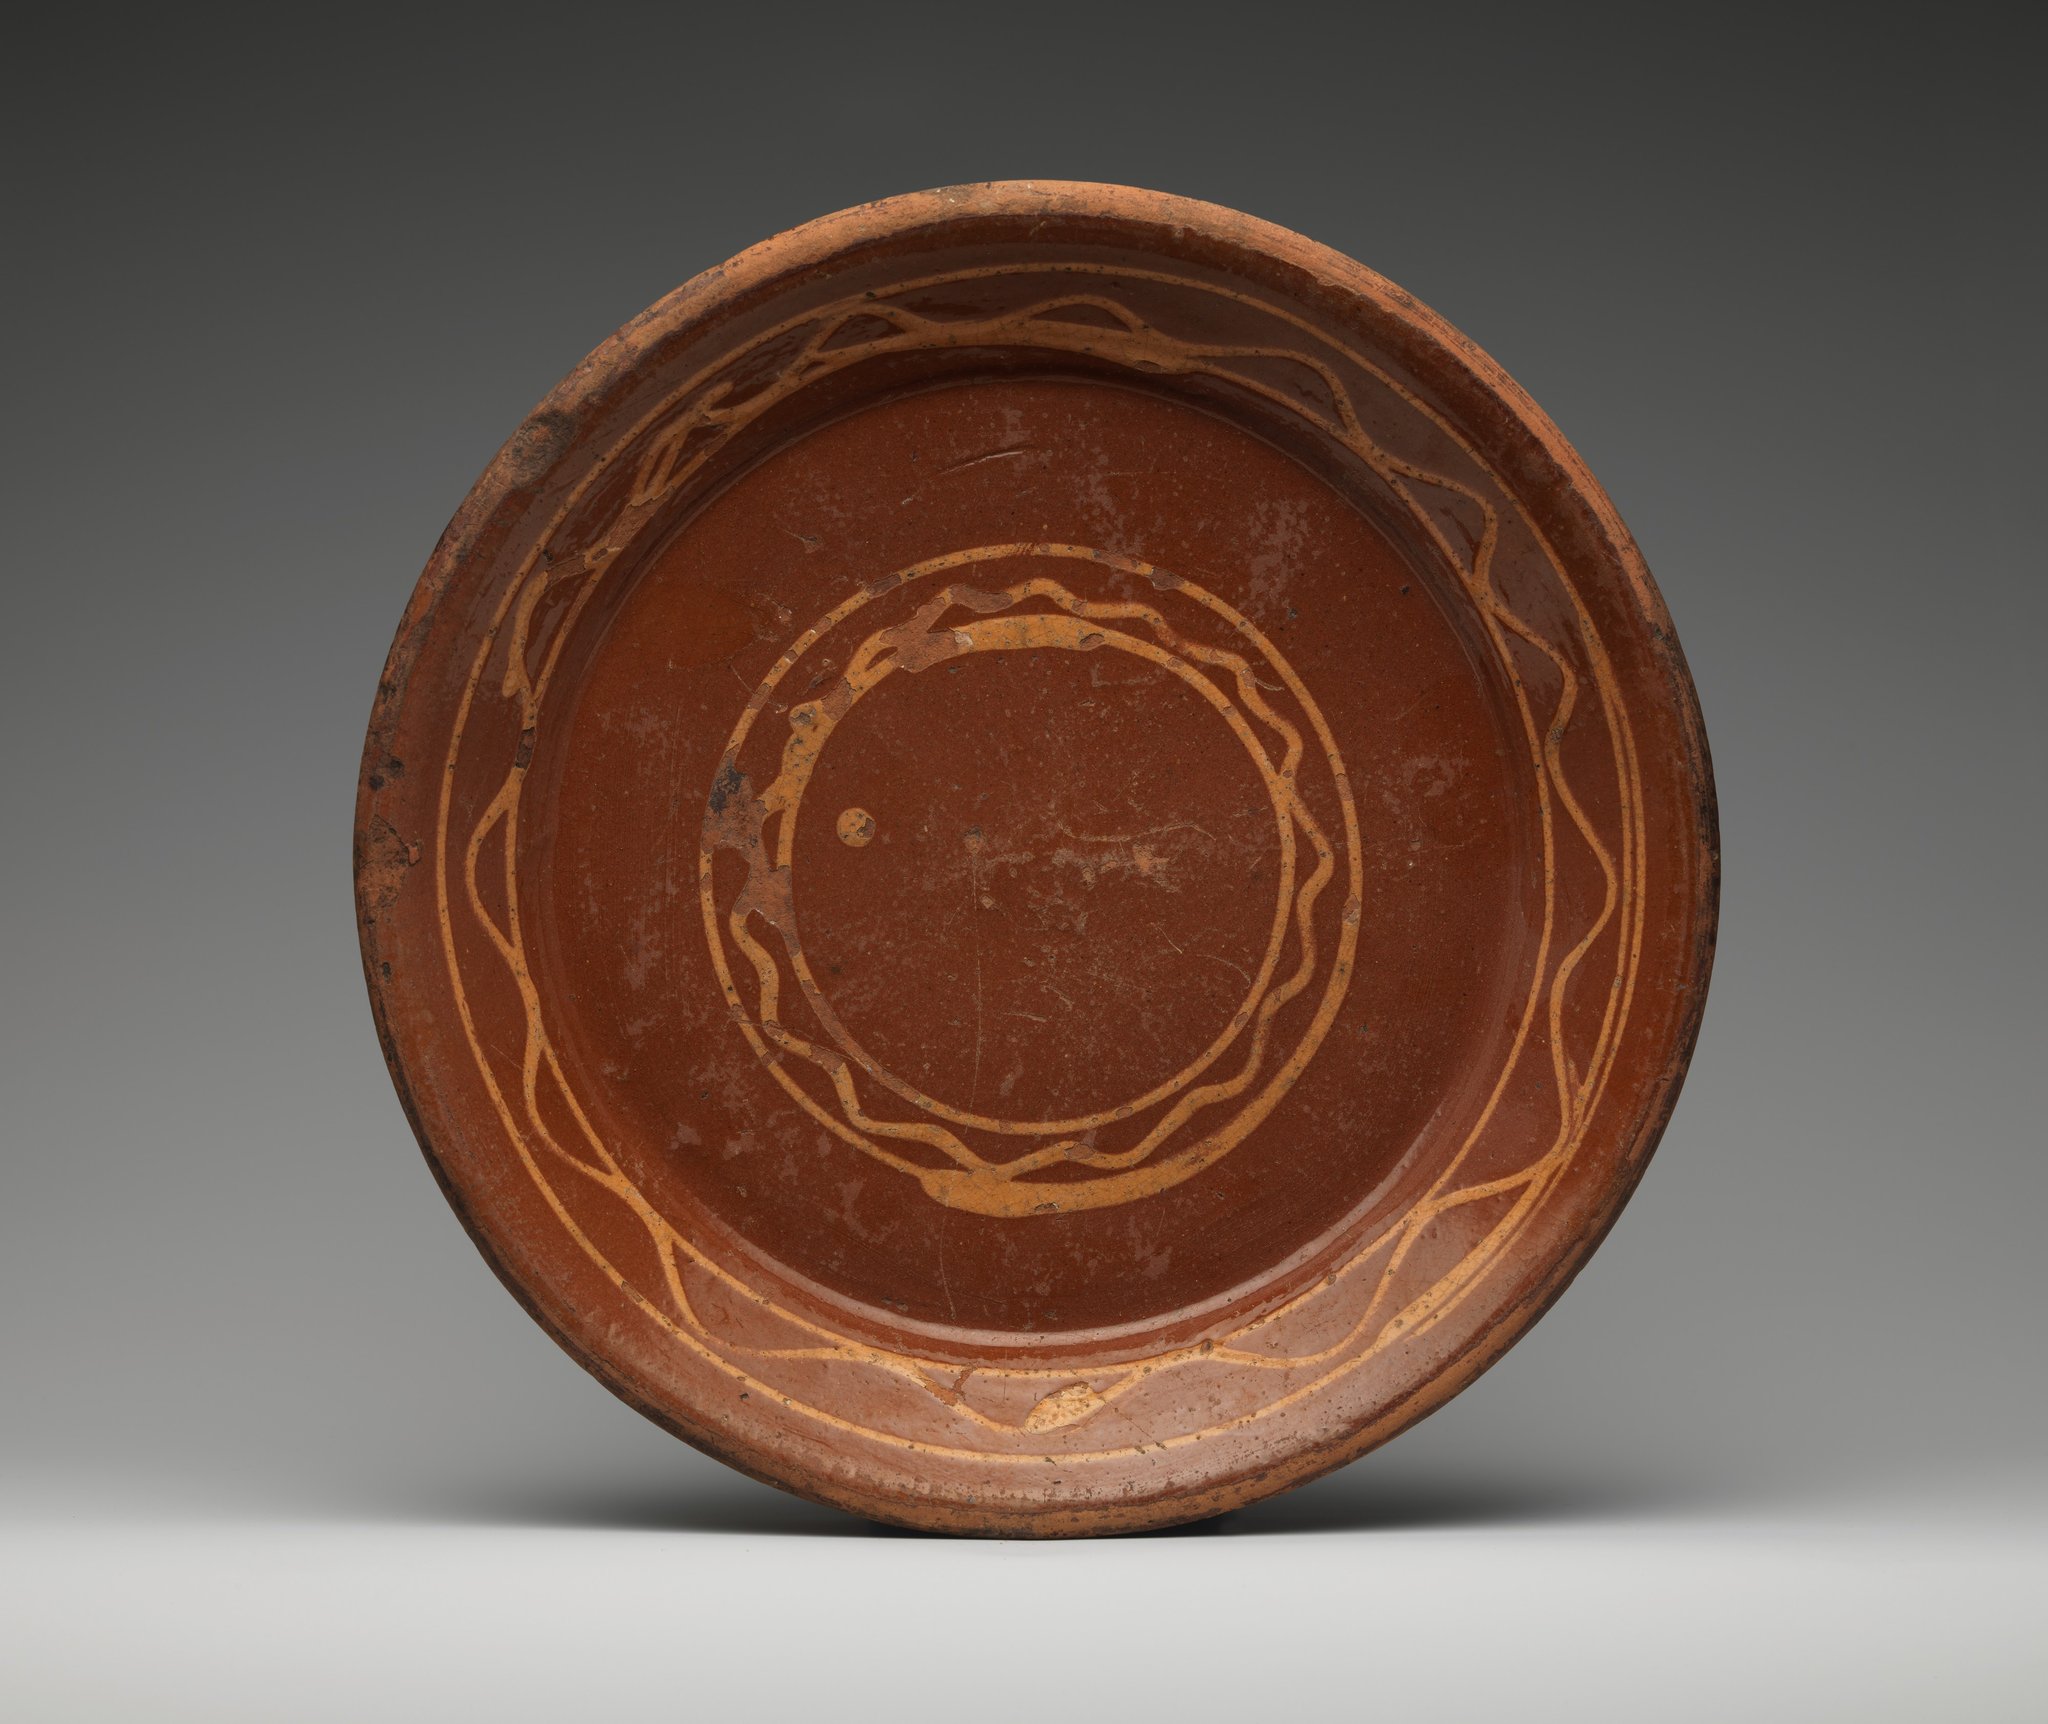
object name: pie dish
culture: american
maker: hervey brooks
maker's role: maker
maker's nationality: american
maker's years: 1779-1873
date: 1803-1867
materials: earthenware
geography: united states